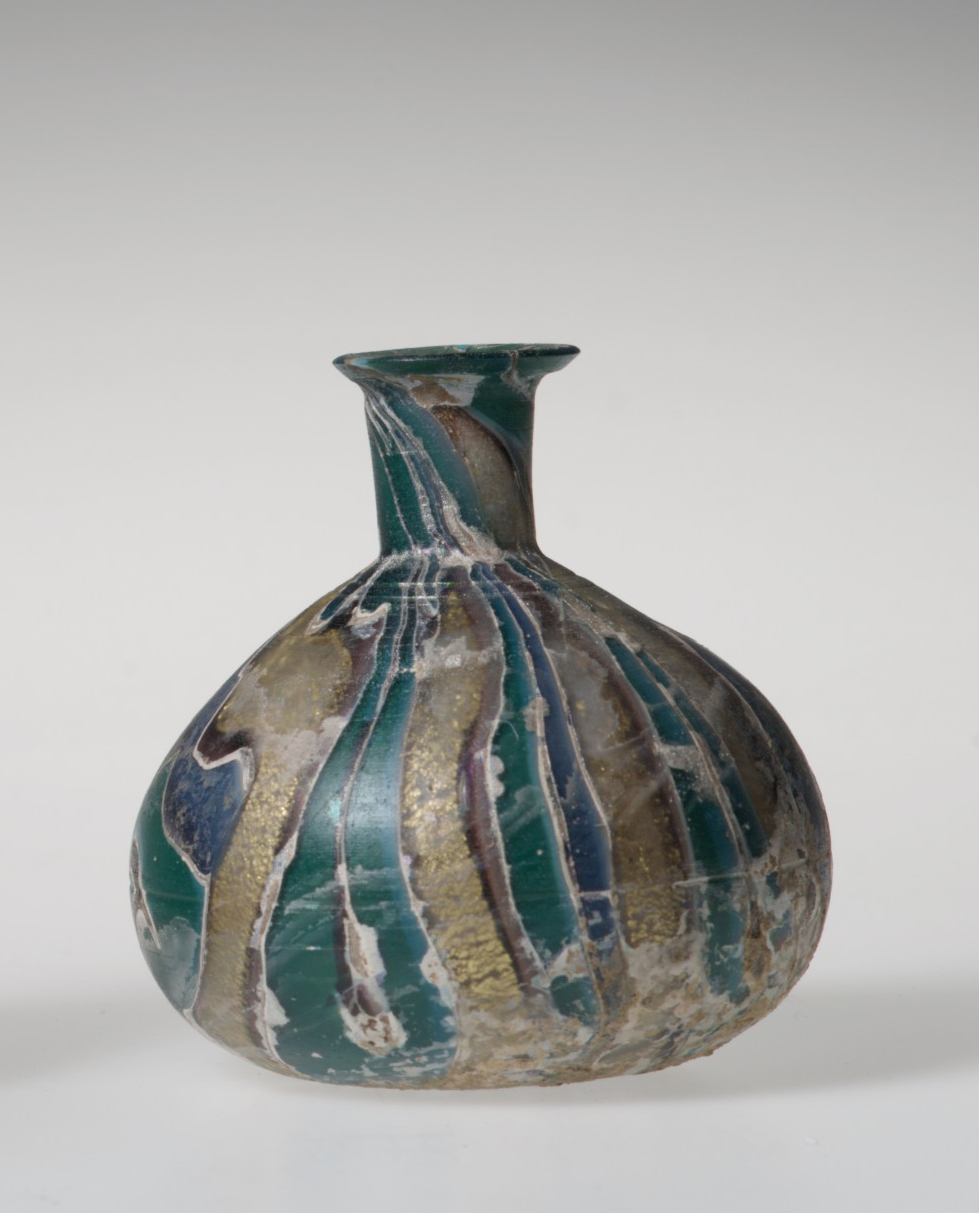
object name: bottle, gold band mosaic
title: Glass gold-band mosaic bottle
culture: roman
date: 1-50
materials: glass